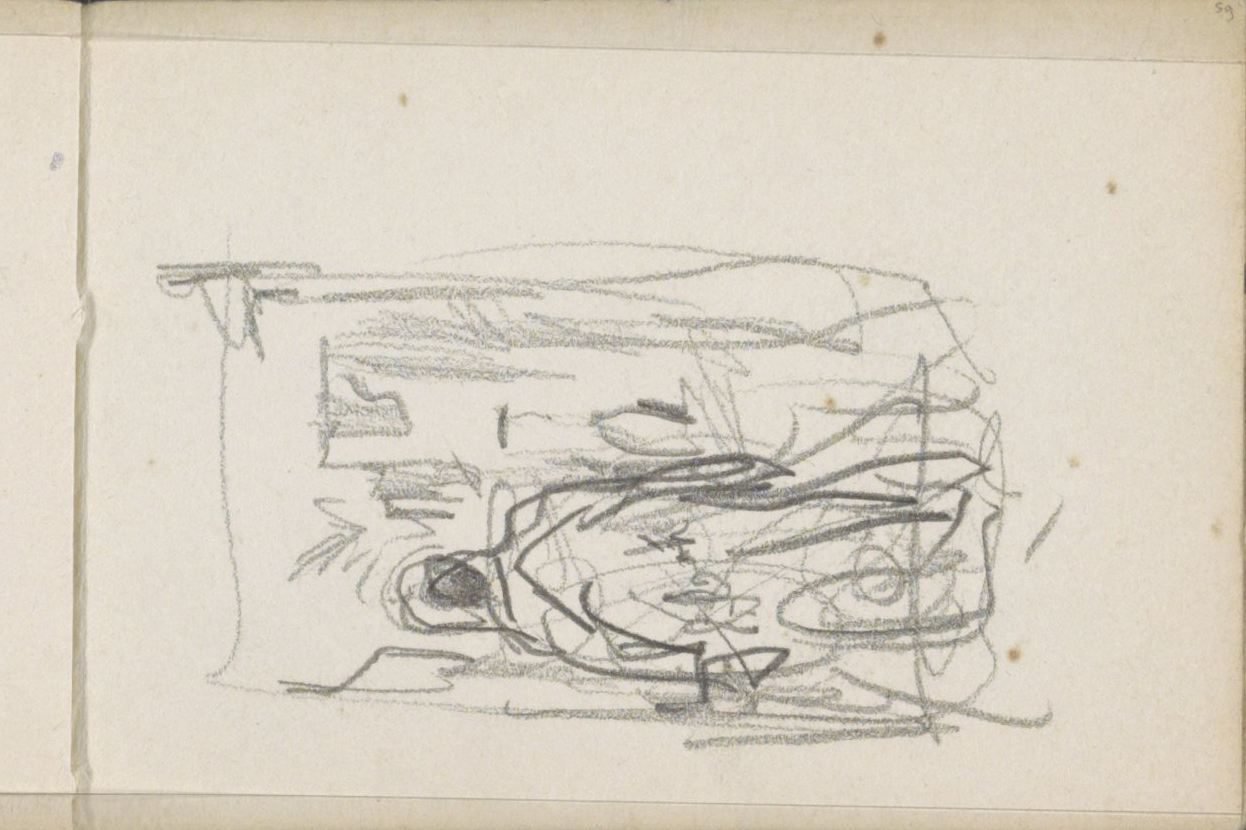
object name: sketchbook leaf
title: Straat met een Algerijn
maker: marius bauer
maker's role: draughtsman, print maker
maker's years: 1867-1932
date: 1922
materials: paper, pencil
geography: biskra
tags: standing figure, africans, street (+ city(-scape) with figures, staffage)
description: De man draagt een traditioneel Noord-Afrikaans gewaad. Pagina 59 uit een schetsboek met 32 bladen.